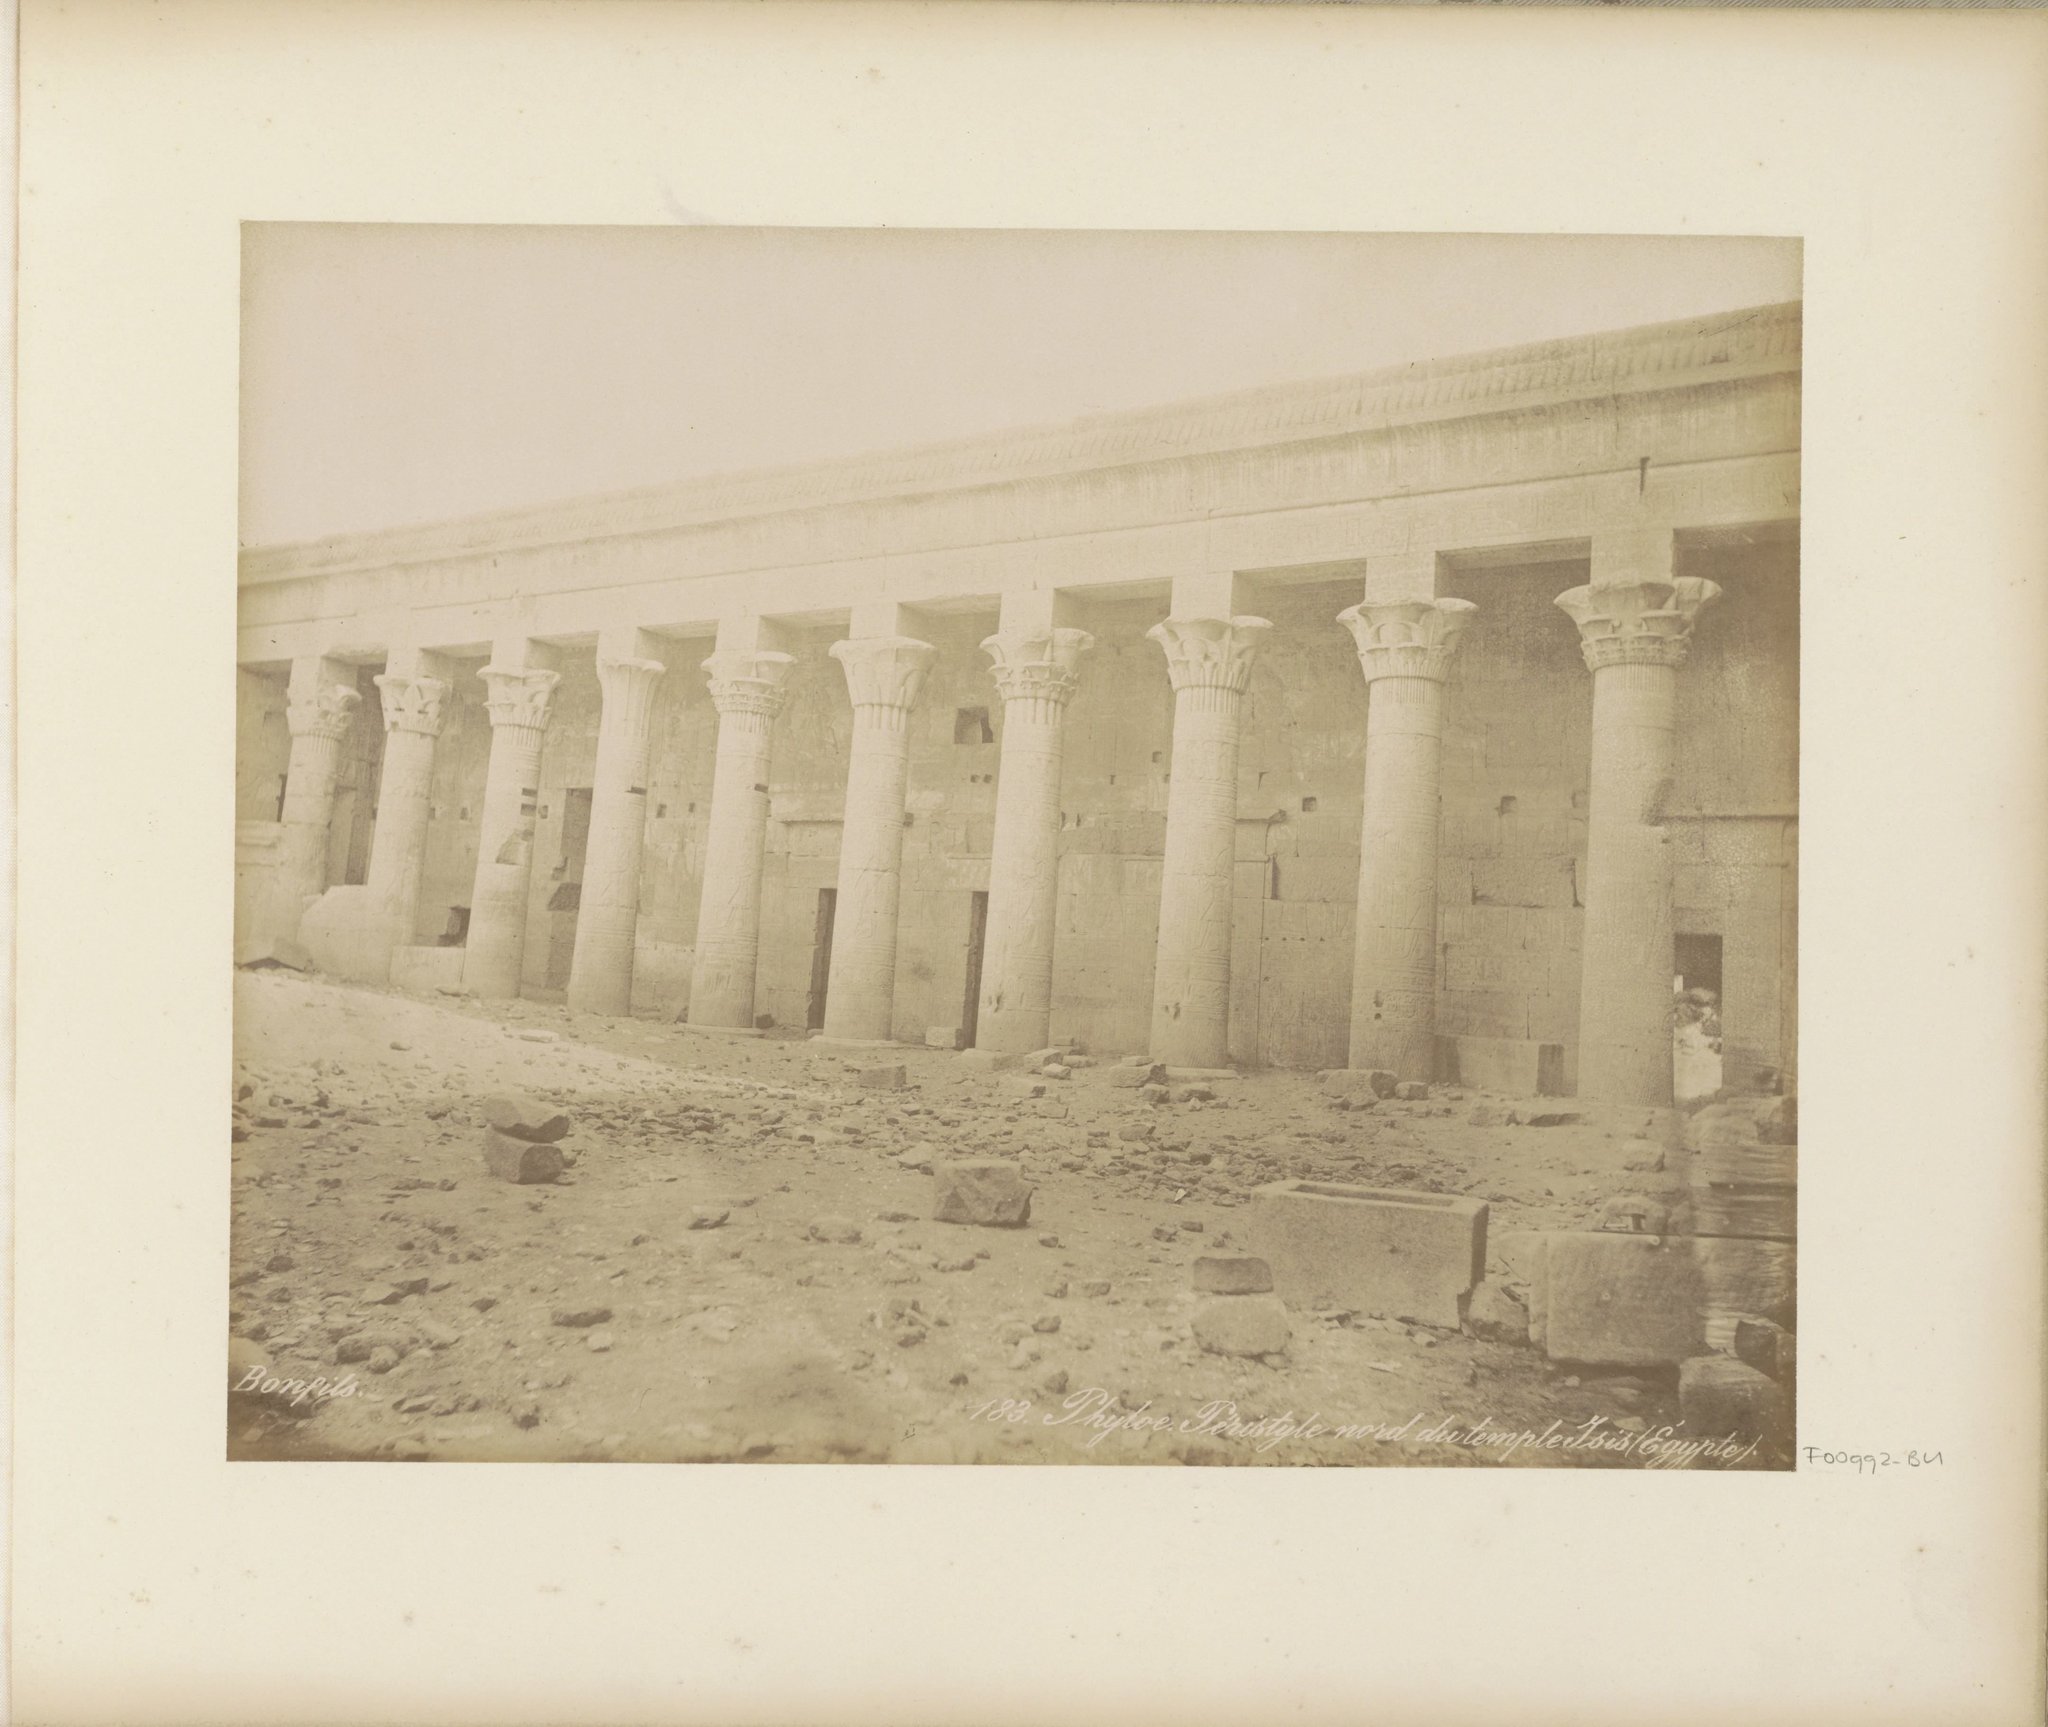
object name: photograph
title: Noordelijke zuilengalerij (peristilium) van de Tempel van Isis op het eiland Philae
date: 1870-1898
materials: cardboard, paper, photographic support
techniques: albumen print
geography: philae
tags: temple, shrine ~ egyptian religion, colonnade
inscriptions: negative number: ‘183’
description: Onderdeel van Reisalbum met 80 foto's van Egypte.